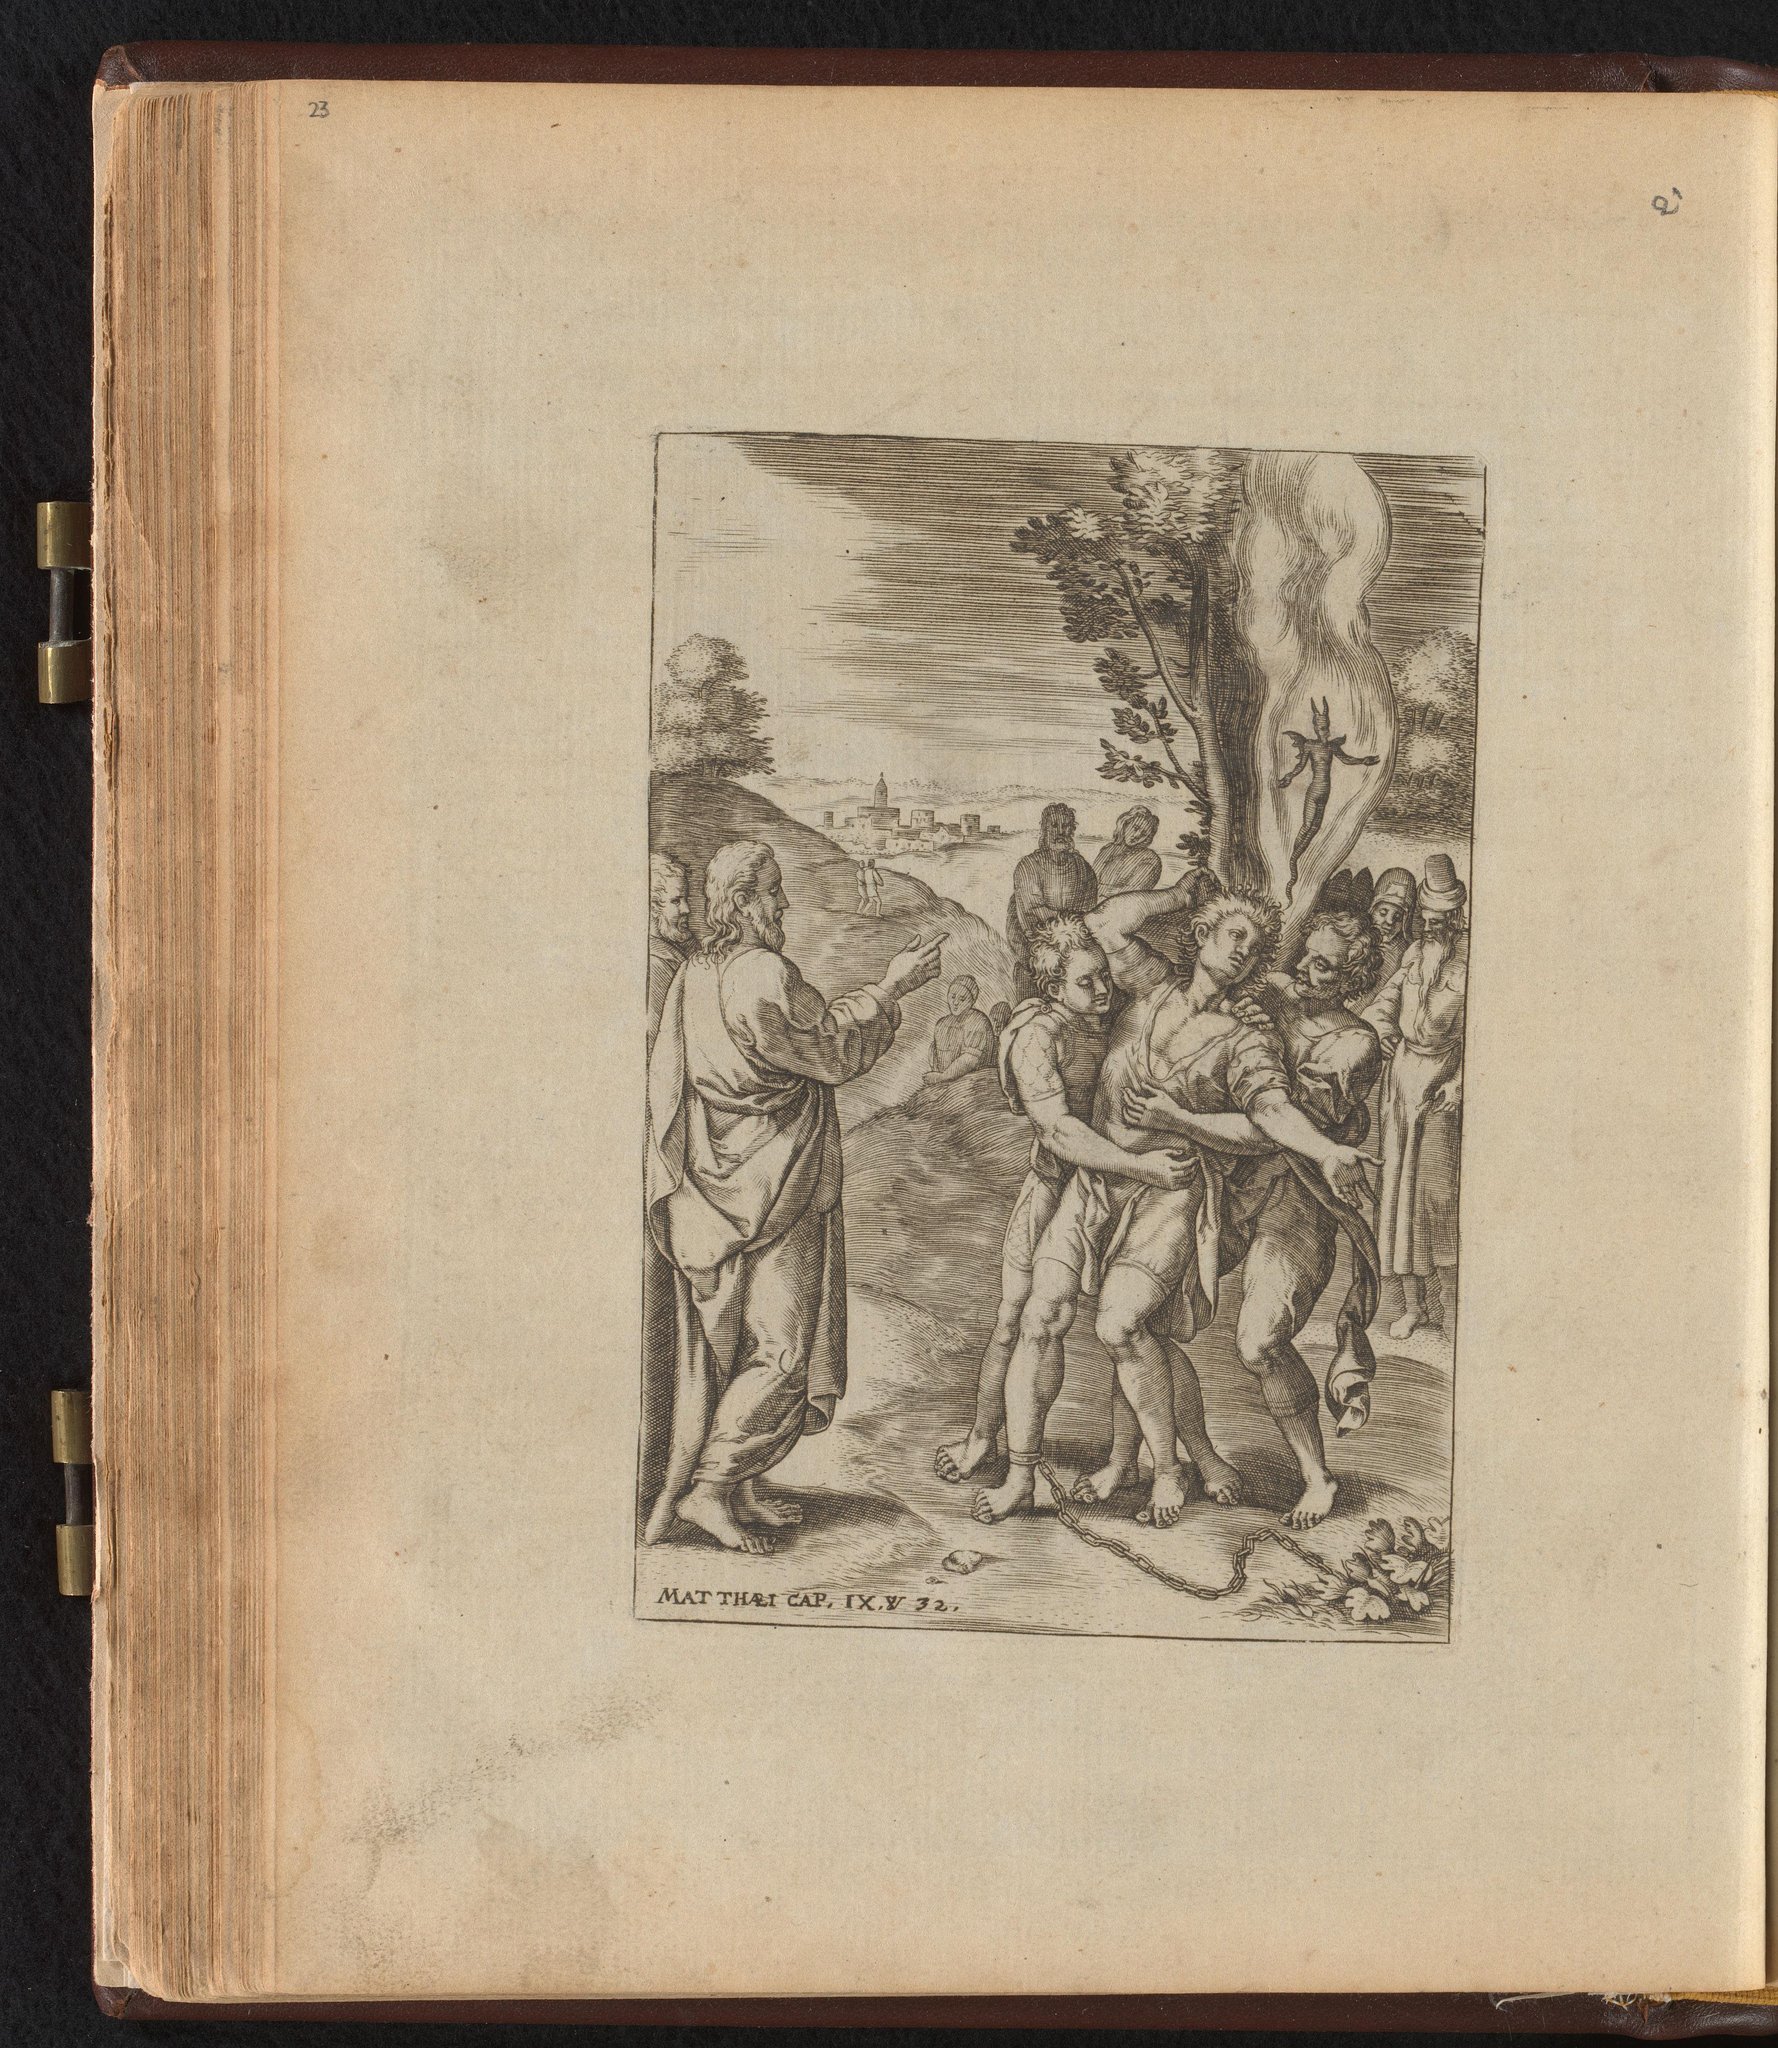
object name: print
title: Christus geneest een bezeten man die niet kon spreken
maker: abraham de bruyn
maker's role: print maker, publisher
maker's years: 1540-1587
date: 1550-1587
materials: paper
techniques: engraving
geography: antwerp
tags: healing of a possessed man who could not speak (matthew 9:32-34; luke 11:14-16)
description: Prent in: s.n. Aldernouwkeurigste verhandelinge der geschiedenissen van het Nieuw Testament (...). Antwerpen: Cornelis Marten Spanoghe, 1783, p. 34-35.